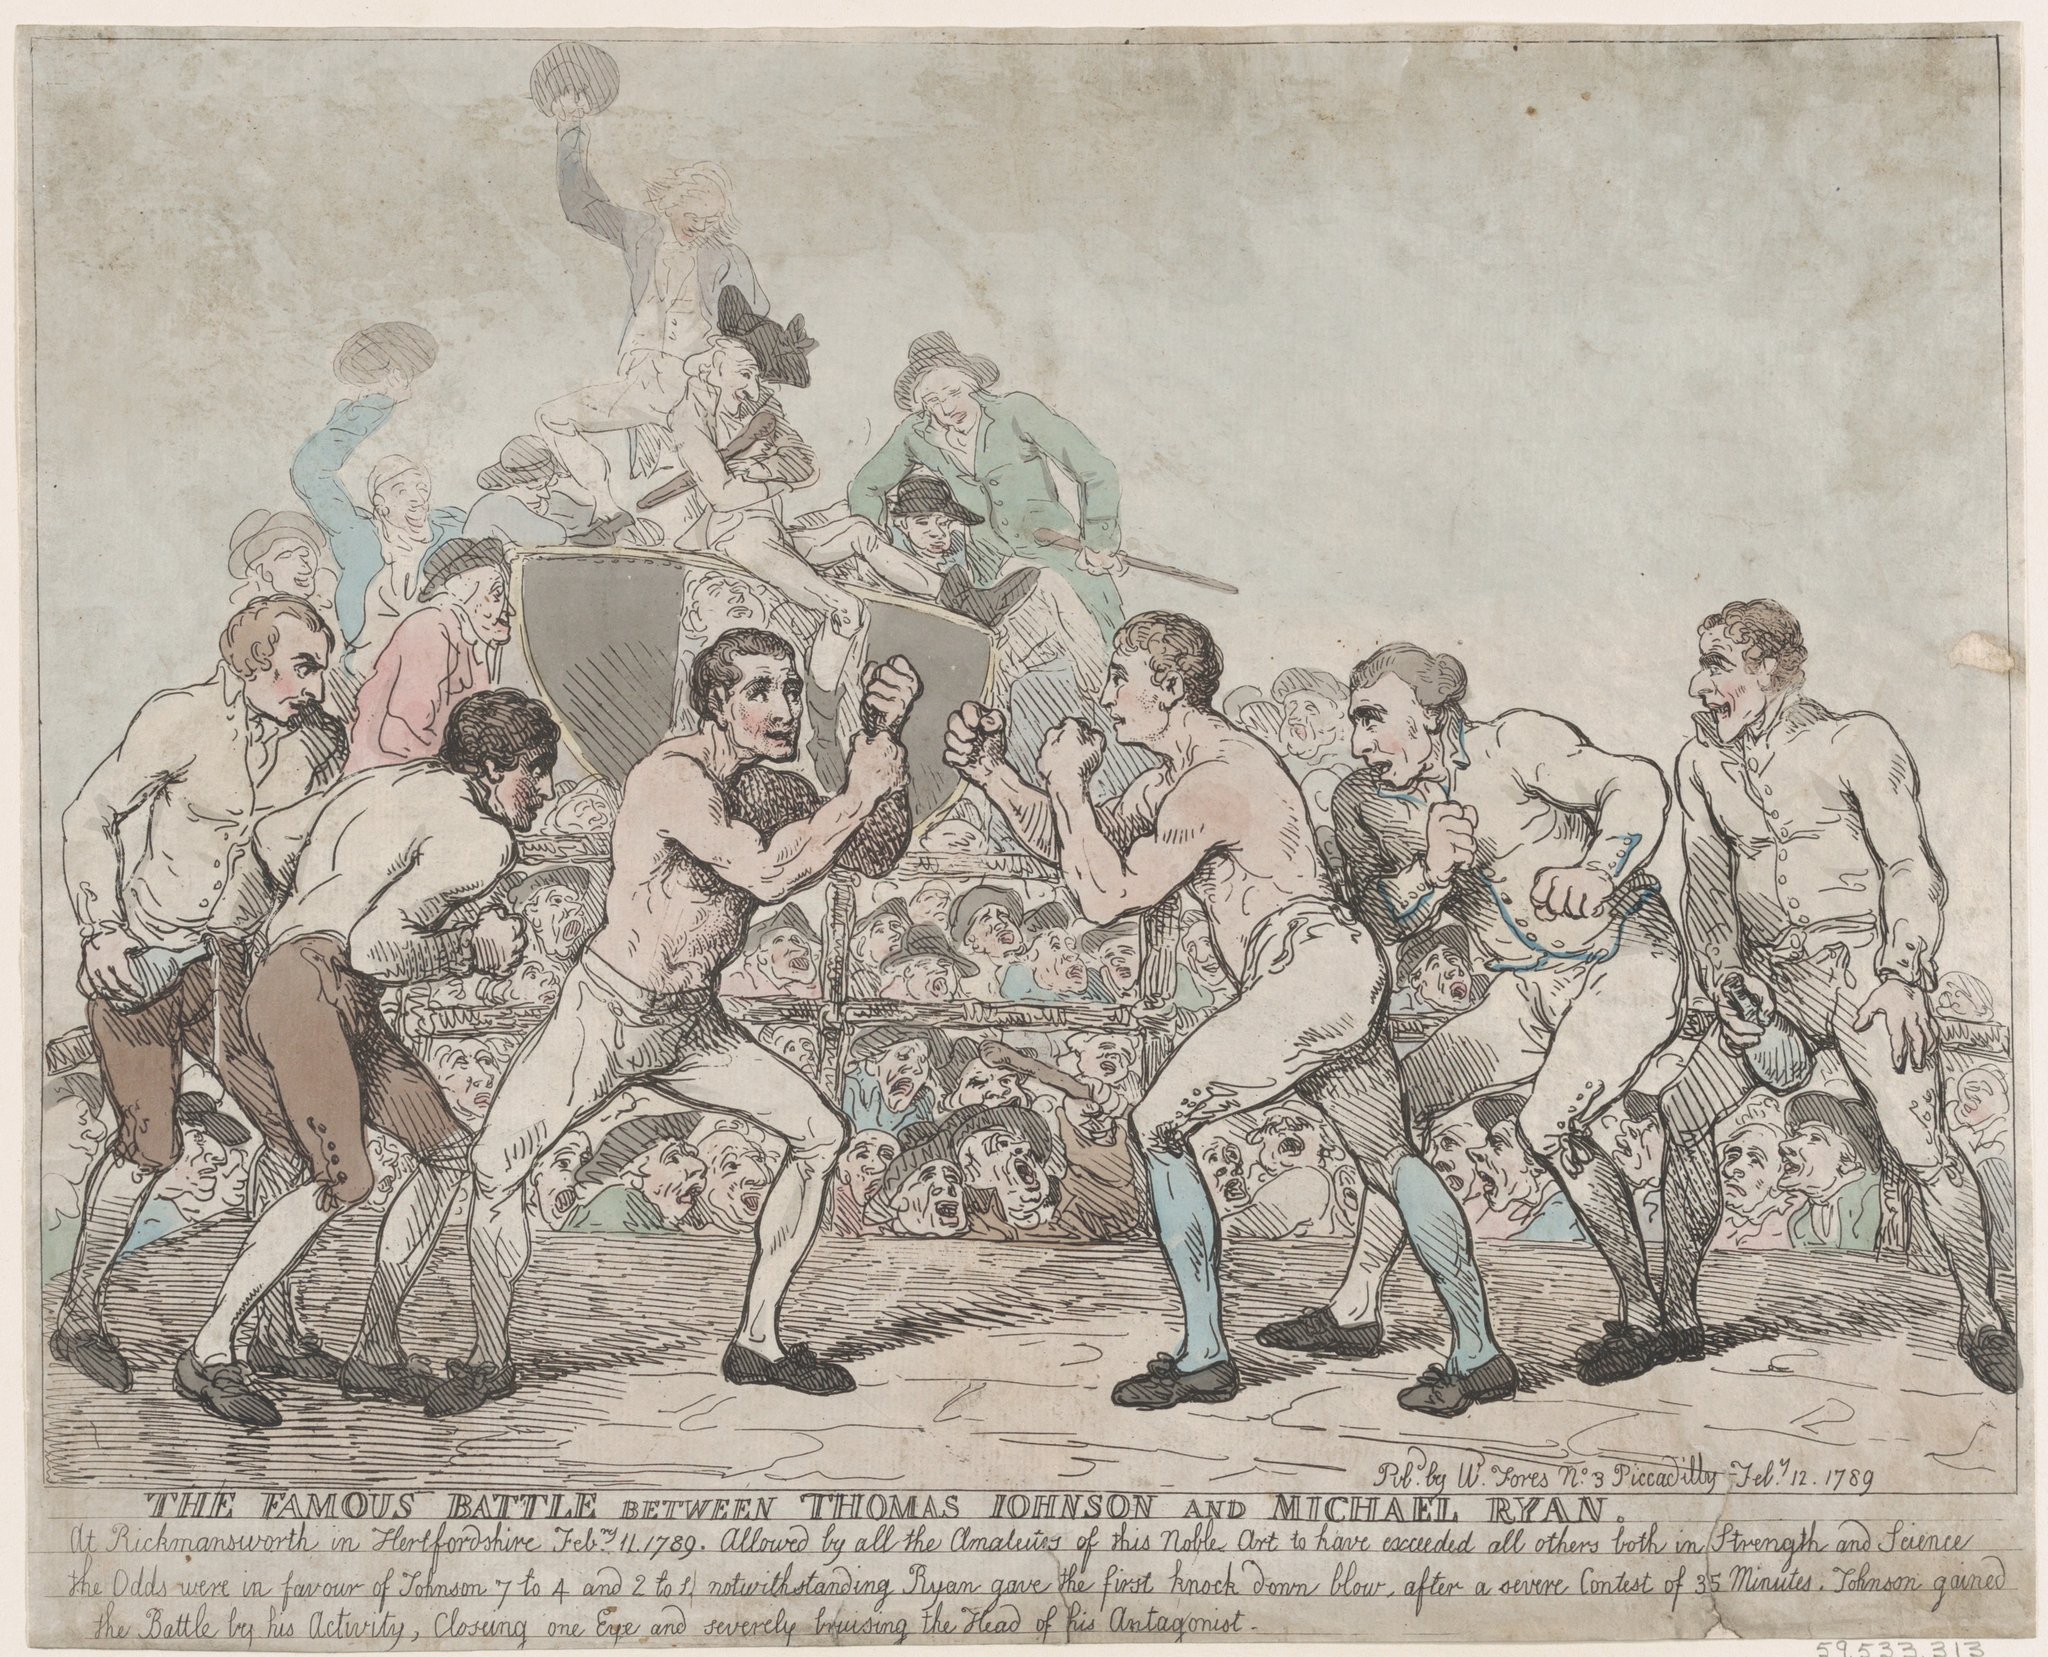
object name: print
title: The Famous Battle Between Thomas Johnson and Michael Ryan, February 11, 1789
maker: thomas rowlandson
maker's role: artist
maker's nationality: british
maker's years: 1757-1827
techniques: etching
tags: men,spectators,boxing,athletes